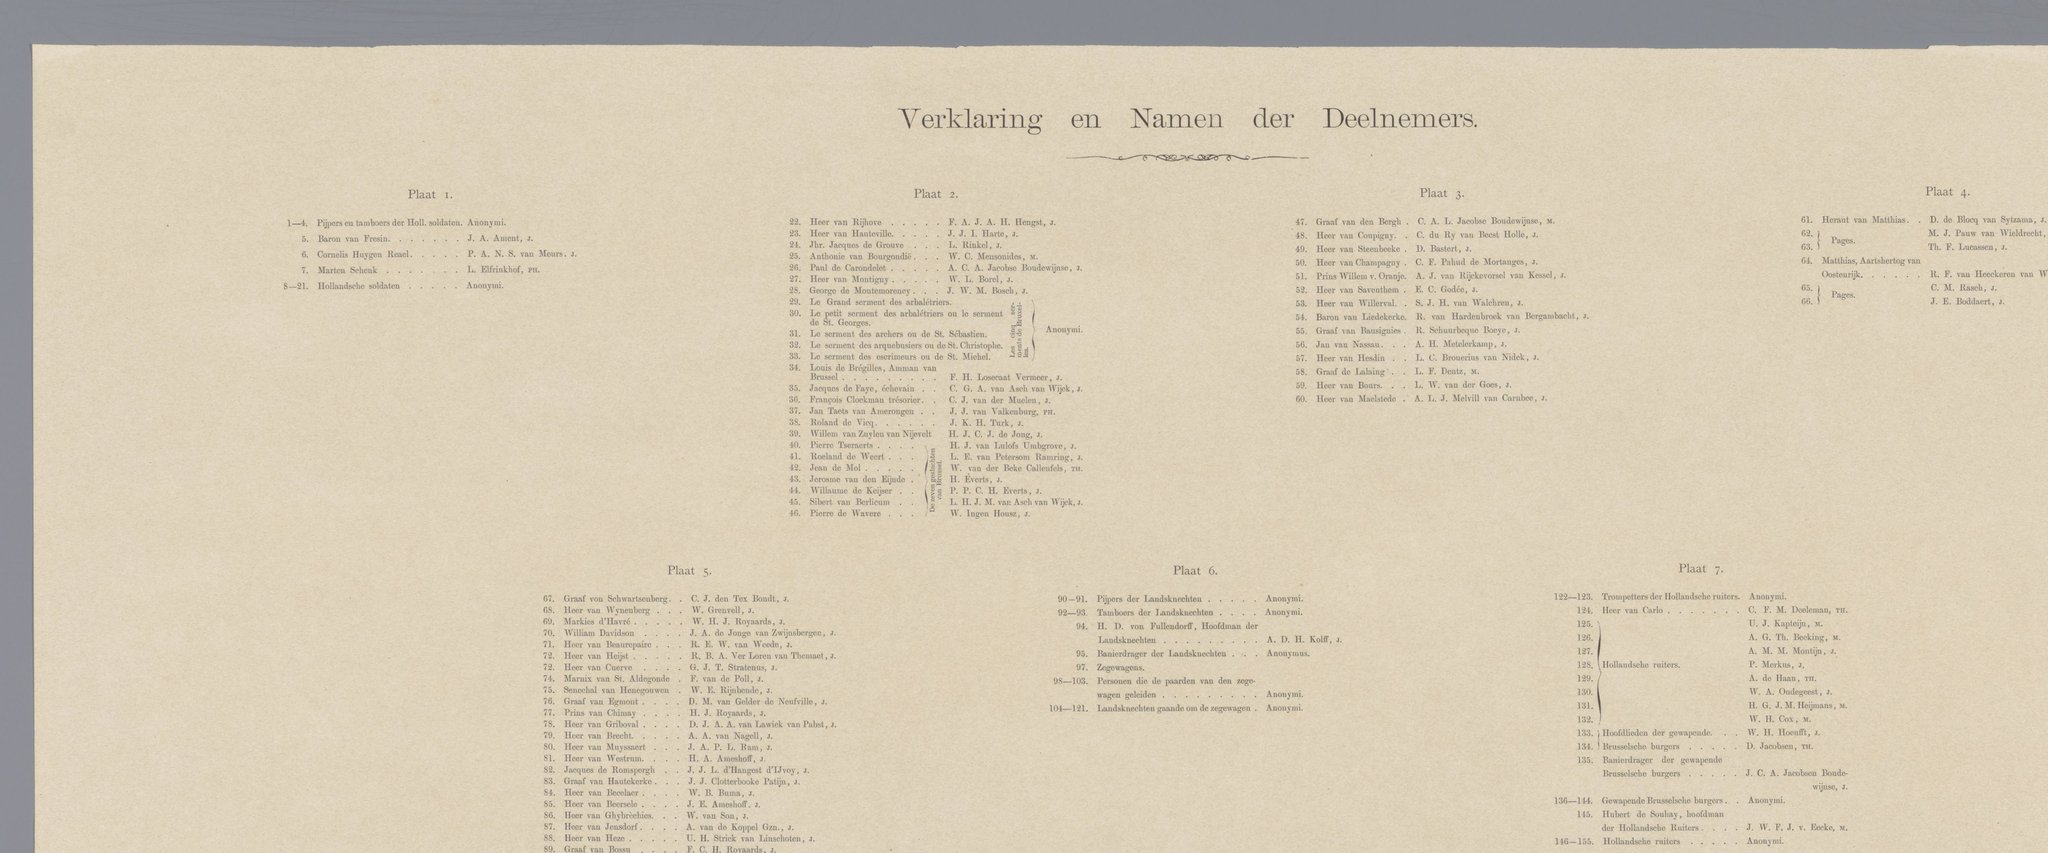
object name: text sheet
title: Utrechtse maskerade van 1881 (verklaring)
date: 1881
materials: paper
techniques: letterpress printing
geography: utrecht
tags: matthias van oostenrijk (rooms-duits keizer), students' pageant, costumes used in pageants, commemoration of the founding of a university, utrecht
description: Tekstblad met een overzicht van de zeven platen met de namen van de voorgestelden en de deelnemende studenten. Onderdeel van de serie van zeven platen plus titelprent van de gekostumeerde optocht door de studenten van de Utrechtse Hogeschool op 28 juni 1881 bij de viering van het 245-jarig bestaan van de Hogeschool. Voorgesteld is de intocht van aartshertog Matthias in Brusssel op 18 januari 1578.